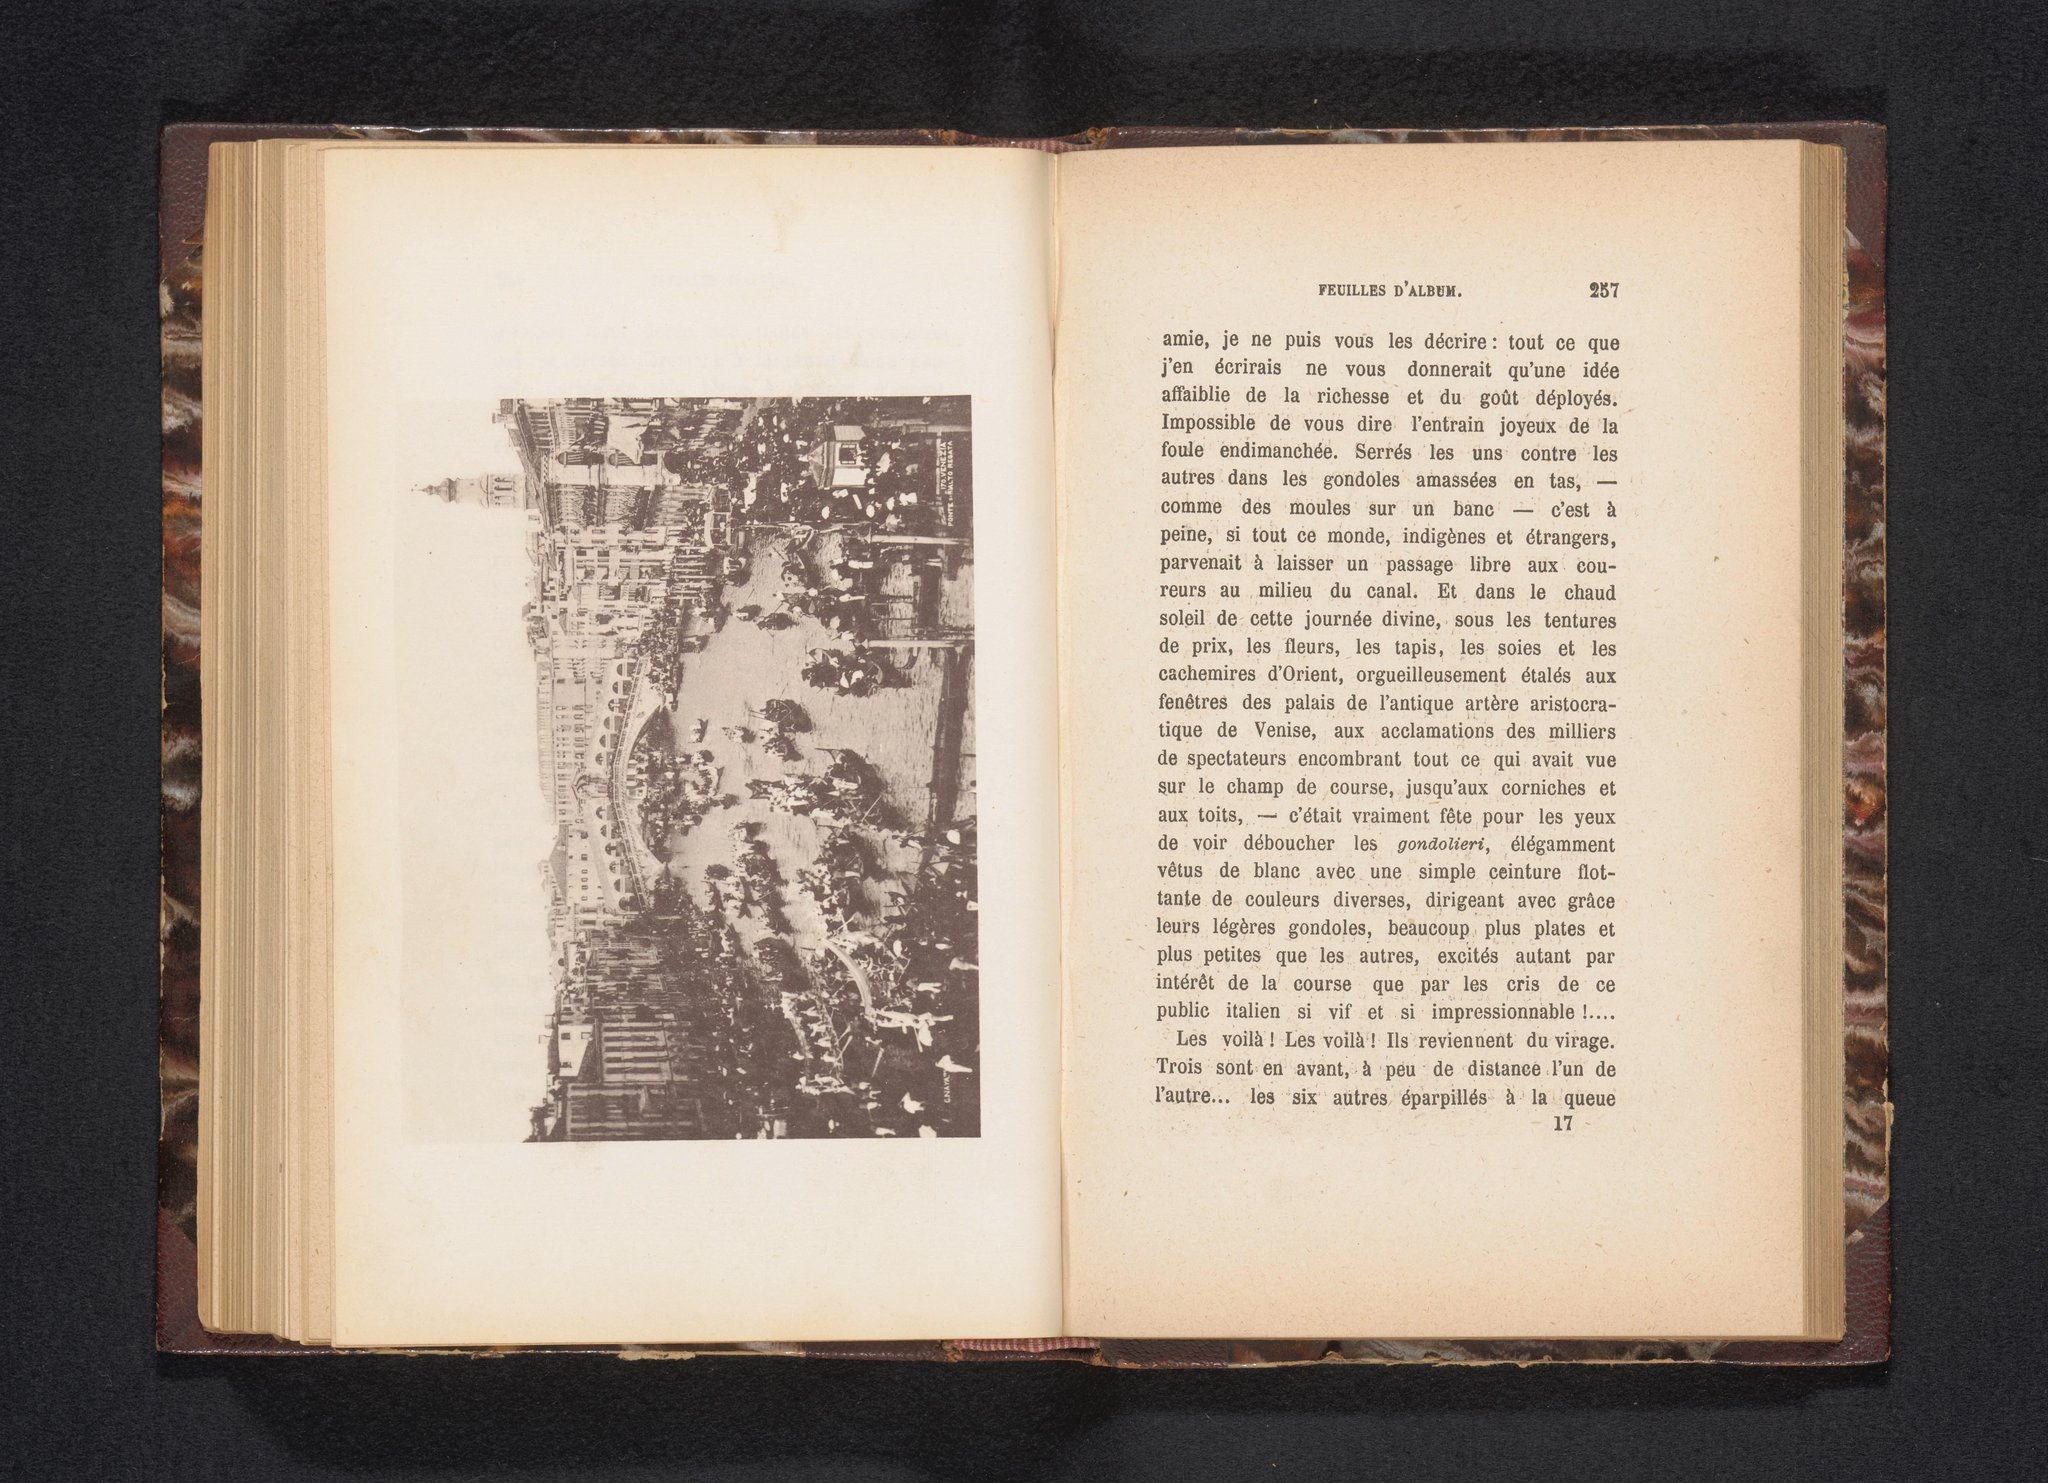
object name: page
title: Venezia, Ponte Rialto regata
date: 1884-1889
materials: paper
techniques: photograph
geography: venice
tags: canals, waters (in city), bridge in city across river, canal, etc.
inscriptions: number: ‘170’